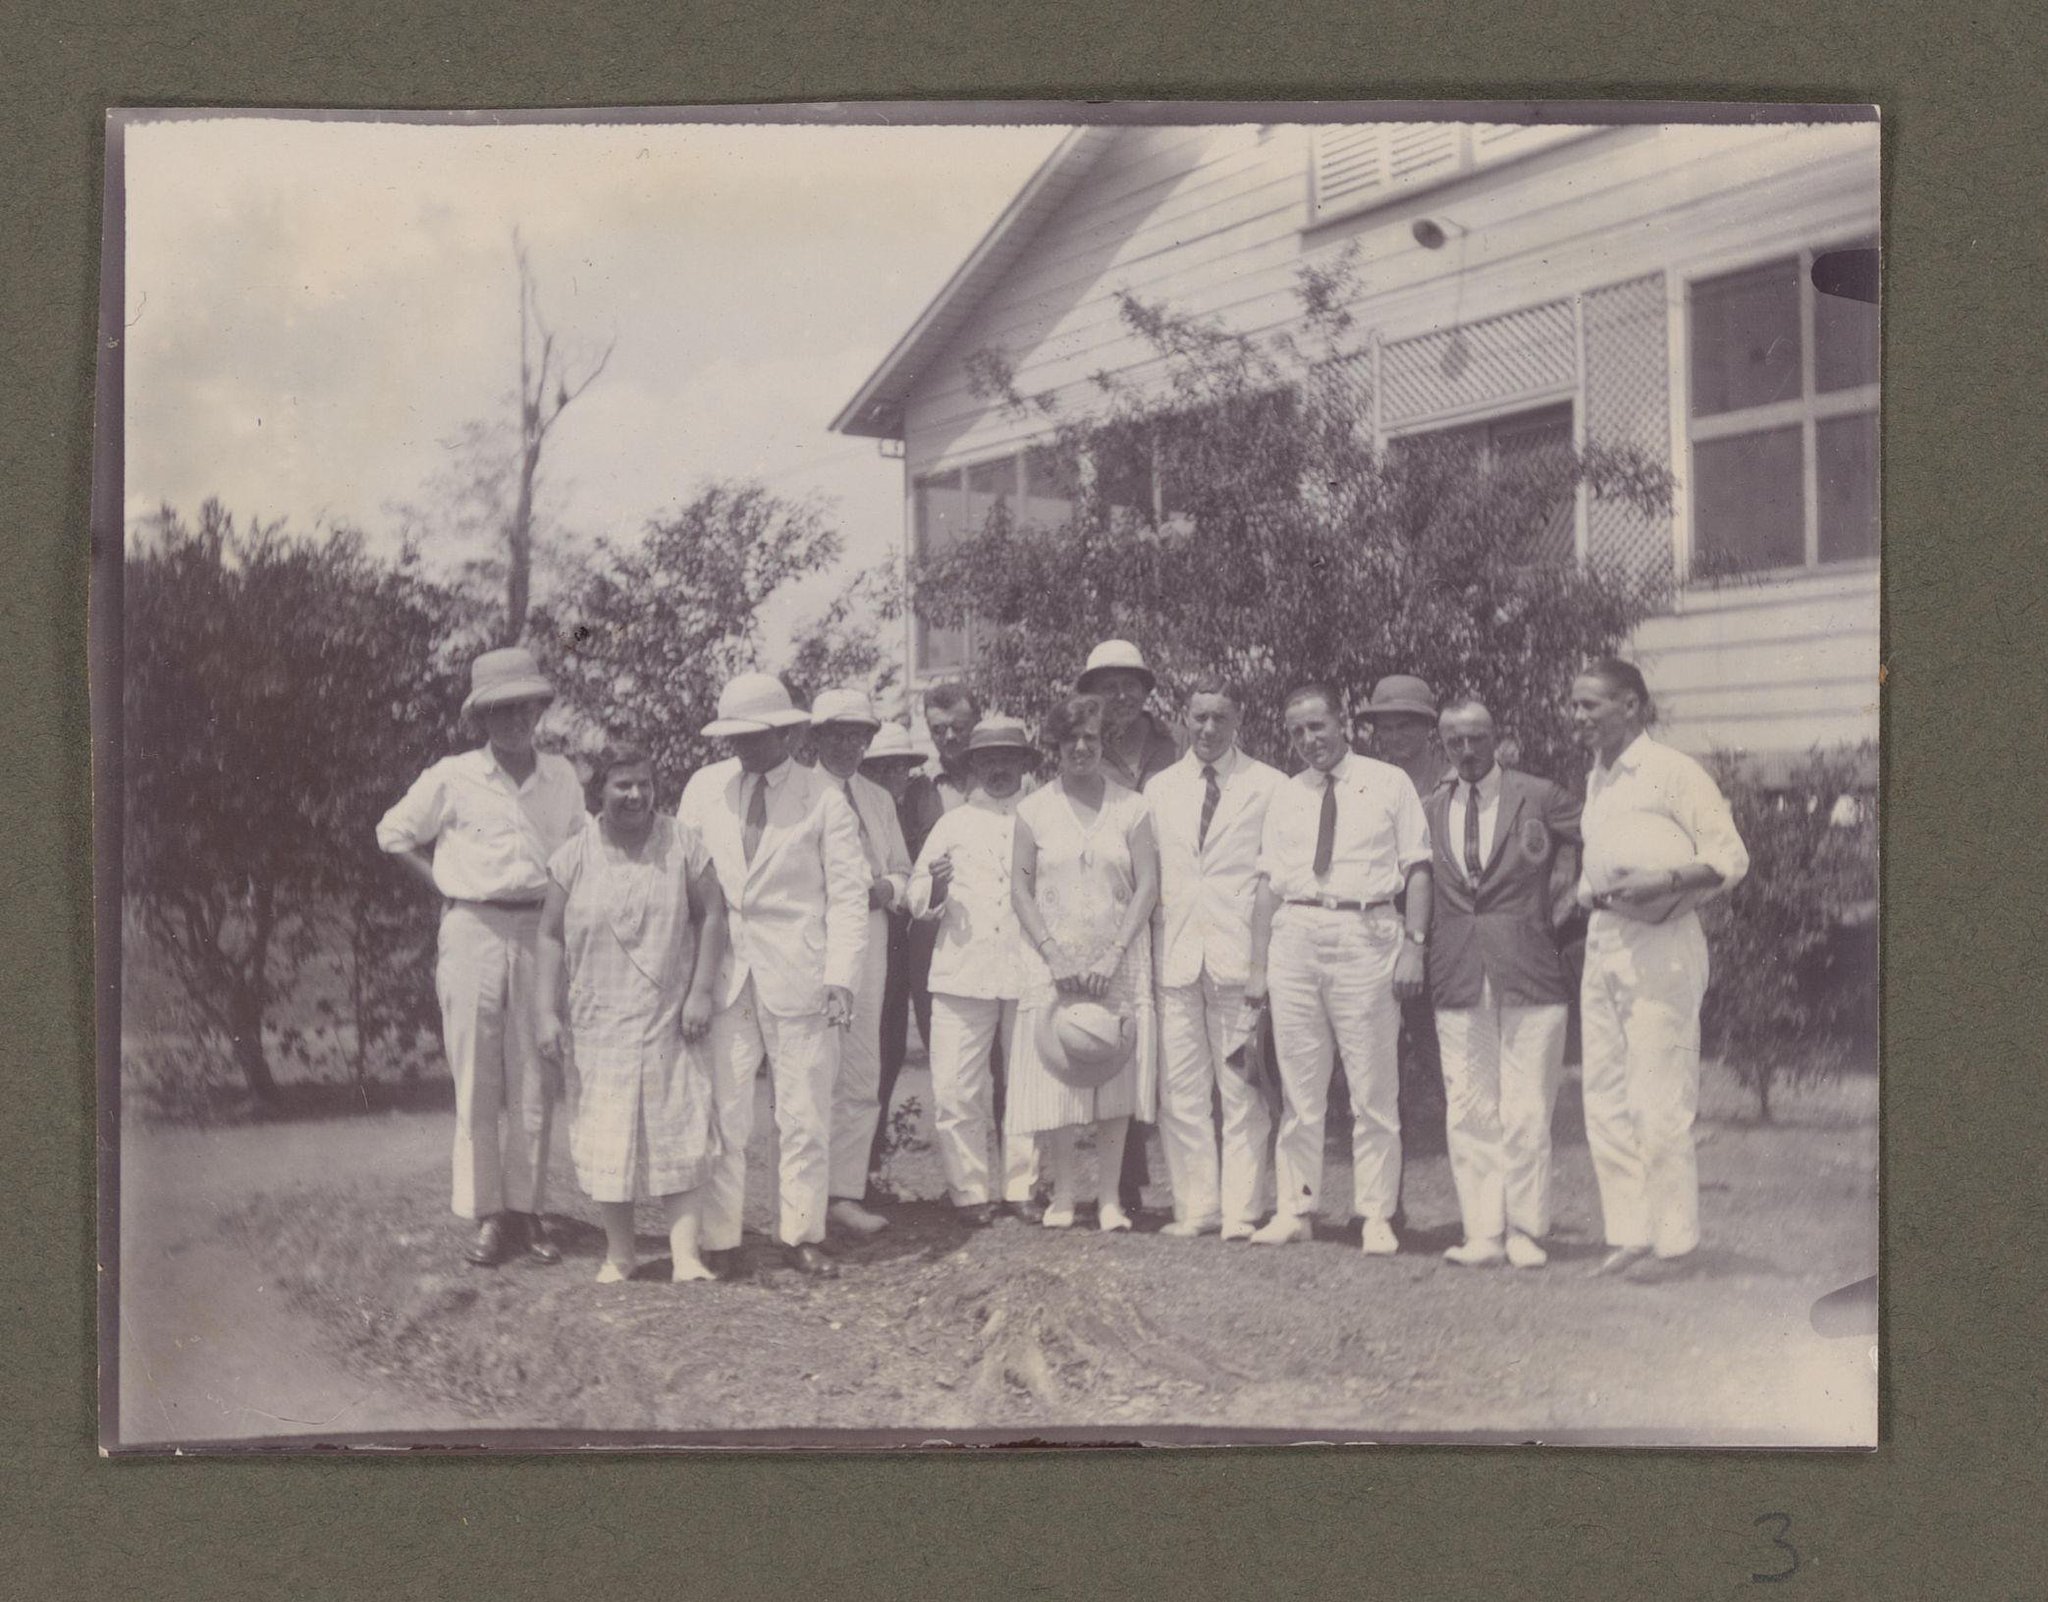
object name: photograph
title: Groepsfoto voor een huis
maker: Anonymous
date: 1925-1927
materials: photographic support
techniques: photography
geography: suriname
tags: jetten, familie, moengo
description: Groepsfoto voor een huis, waarschijnlijk te Moengo. Foto op een bladzijde van een los albumblad. Onderdeel van het ensemble met foto's van de familie van ingenieur Jetten in de mijnbouwstad Moengo in Suriname.